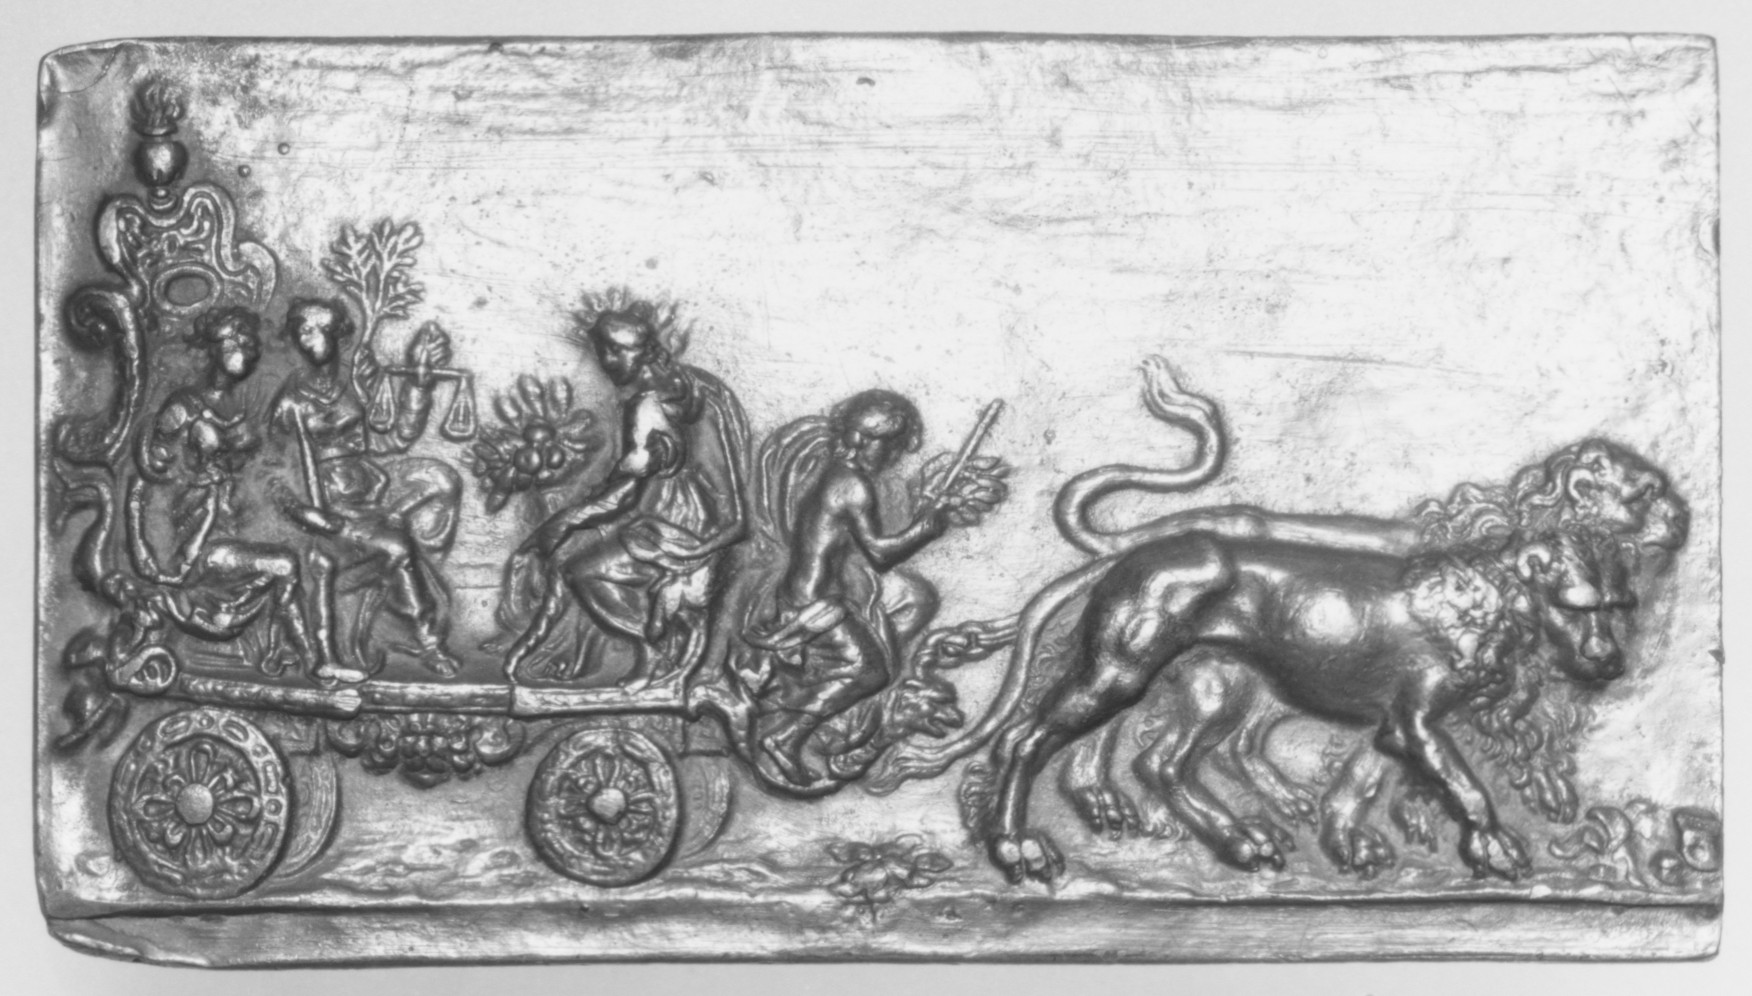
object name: plaquette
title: The Triumph of Virtues: Justice, Peace and Abundance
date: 1576-1600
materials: lead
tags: men,lions,chariots